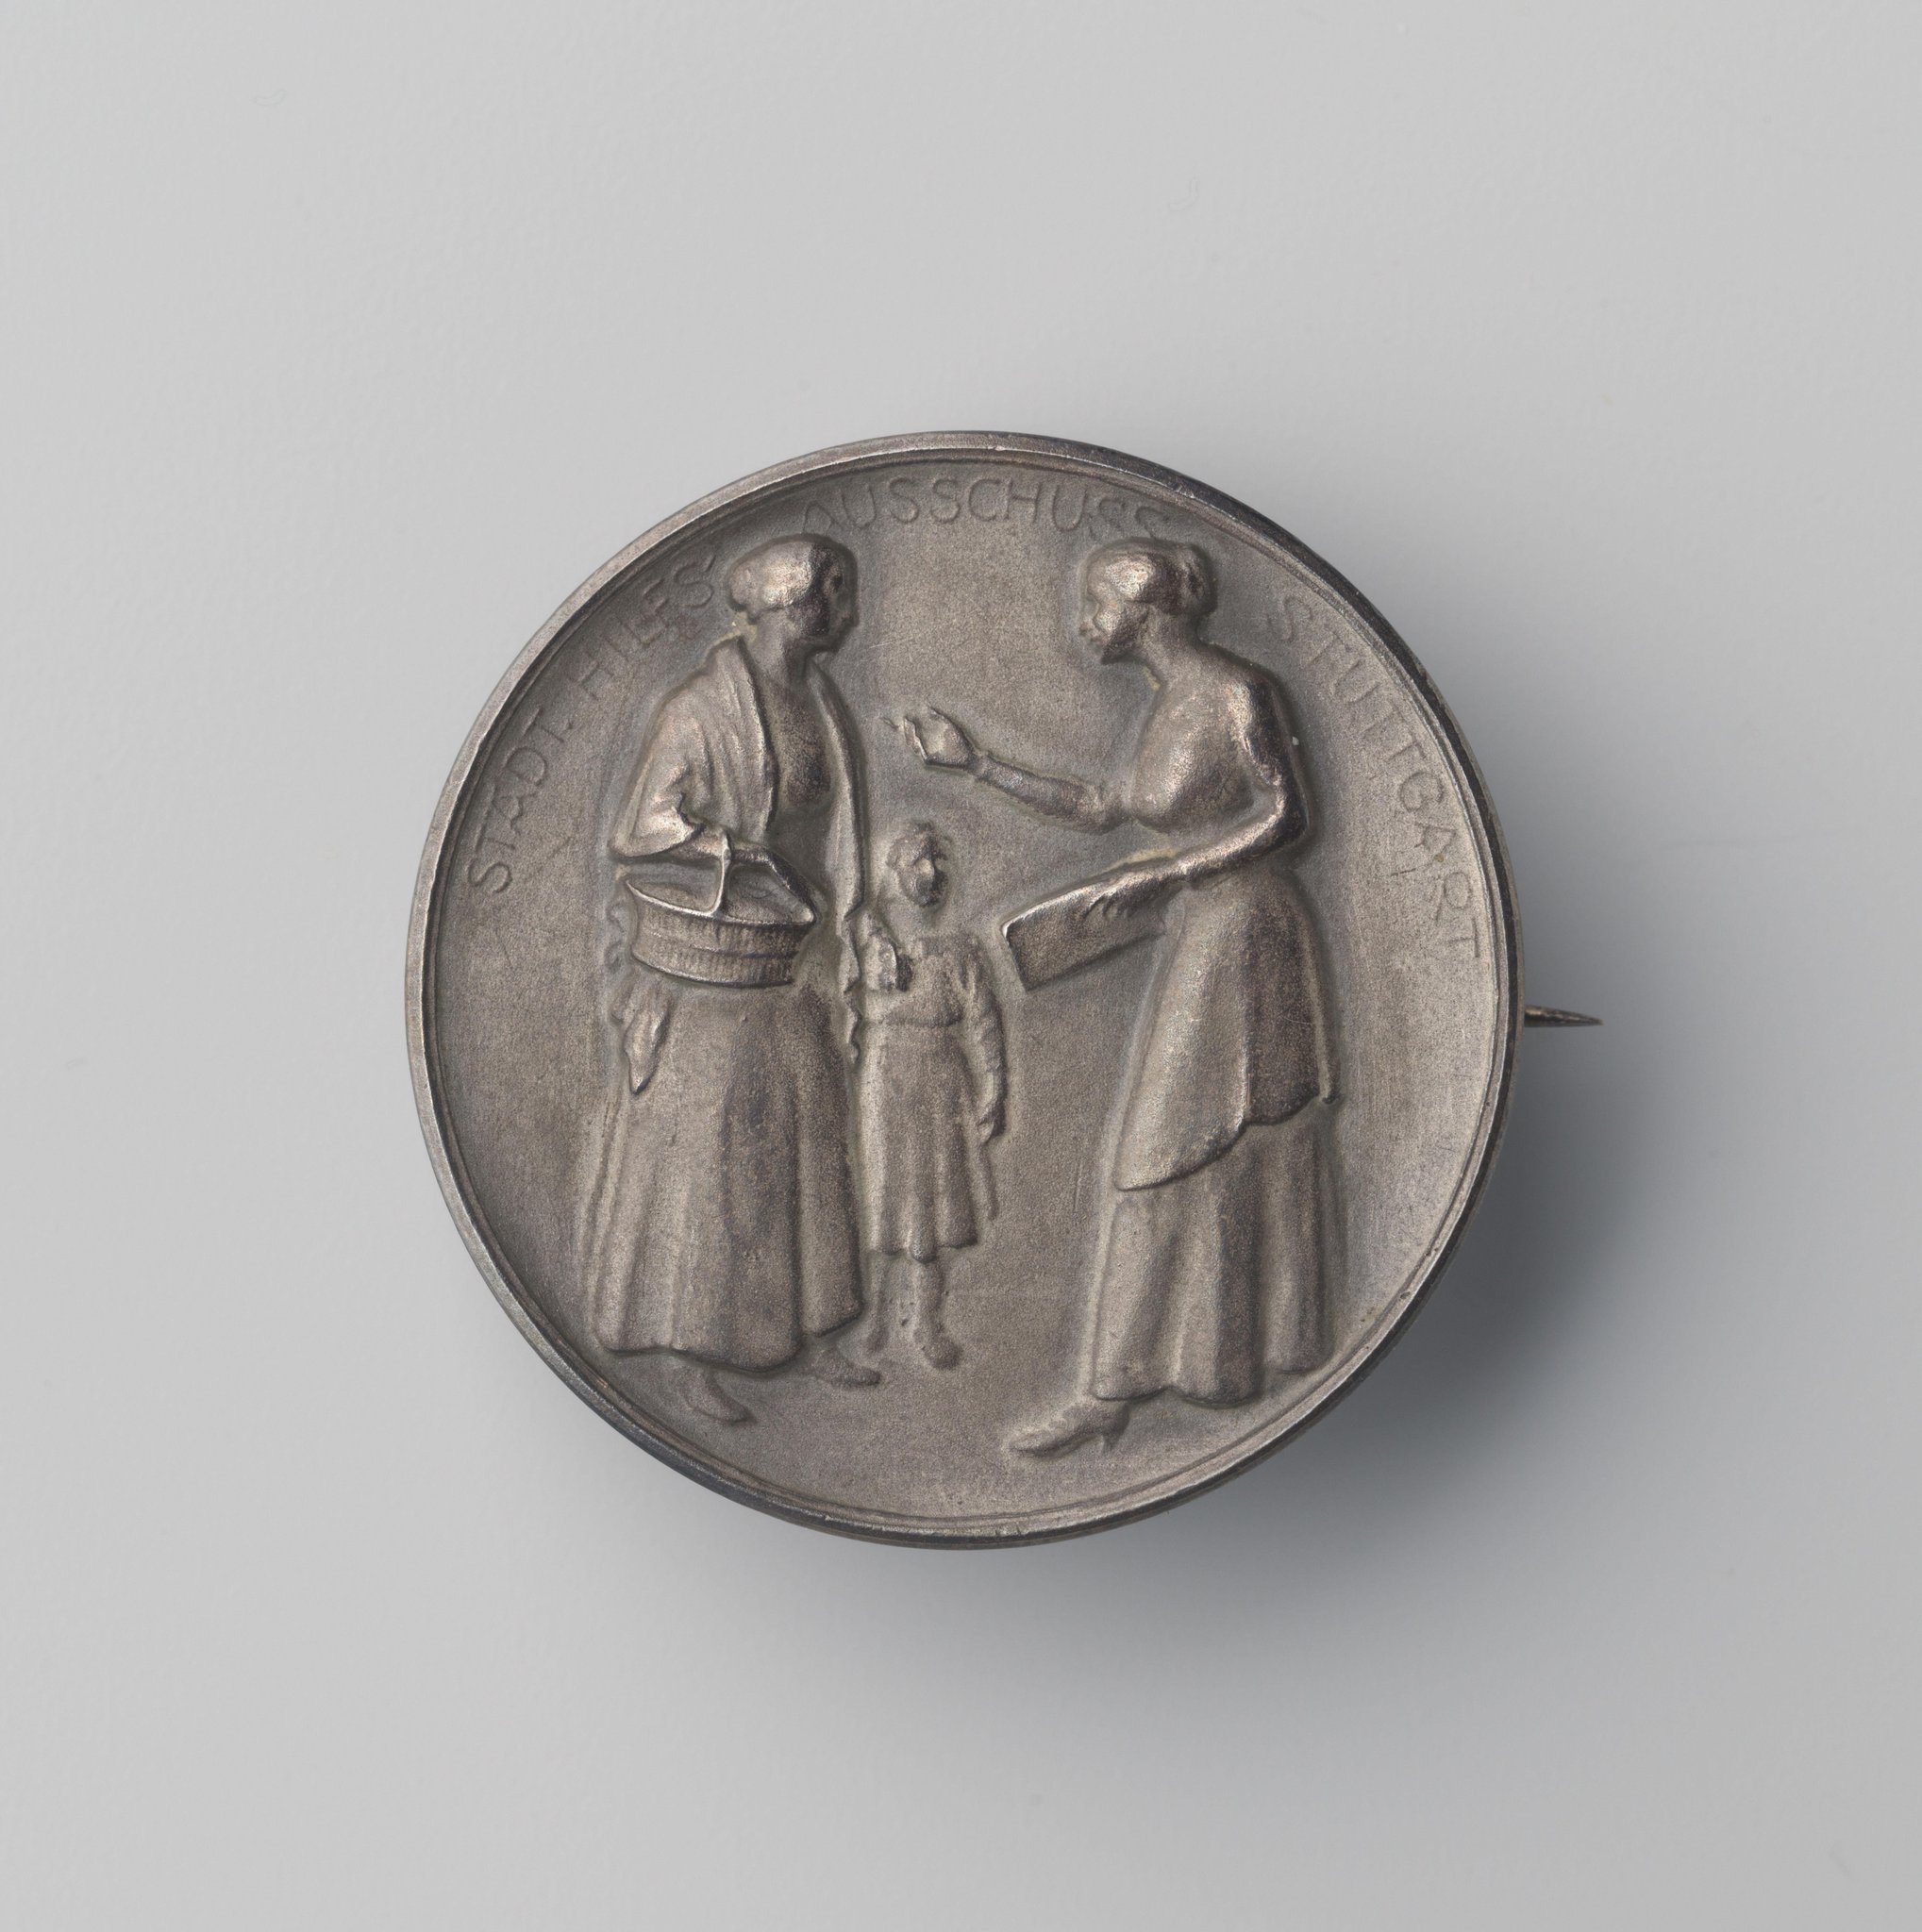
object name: pin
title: Speld Rode Kruis 'Württemberg. Landesverein'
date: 1900-1925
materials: metal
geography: stuttgart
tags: eugen wachenheimer, else wachenheimer-moos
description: Dit object is onderdeel van de nalatenschap van Isabel Elon-Wachenheimer (1928-2010). Tot haar overlijden behoorde het samen met de andere objecten uit de nalatenschap tot haar privédomein van Isabel Wachenheimer. In die particuliere context zijn deze objecten tezamen en individueel aandenkens - aan de jeugd, ouders en familie van Isabel Wachenheimer vóór en tijdens de Shoah en aan haar leven na de Tweede Wereldoorlog. Isabel Wachenheimer, die van juni 1943 tot mei 1945 gevangen zat in Kamp Westerbork, Theresienstadt, Auschwitz, Lenzing a/d Oberdonau (een buitenkamp van Mauthausen), overleefde de Shoah. Haar ouders – Eugène Wachenheimer en Else Wachenheimer-Moos - werden op 14 oktober 1944 in Auschwitz-Birkenau vermoord.